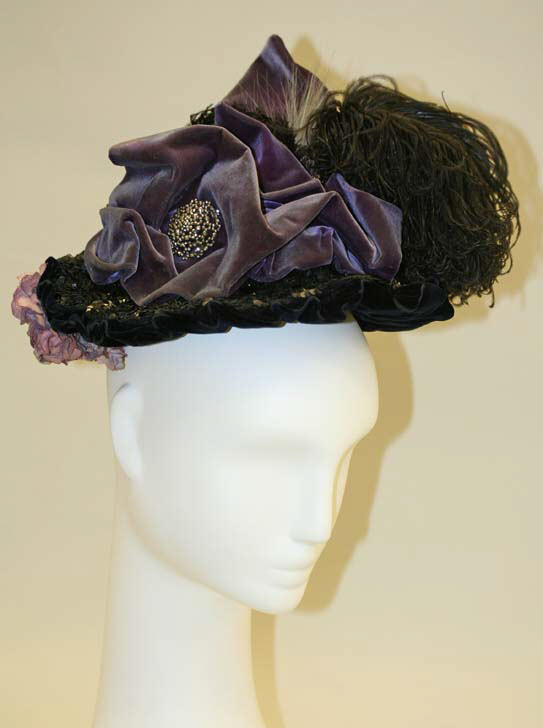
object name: hat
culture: american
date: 1897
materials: feather, silk